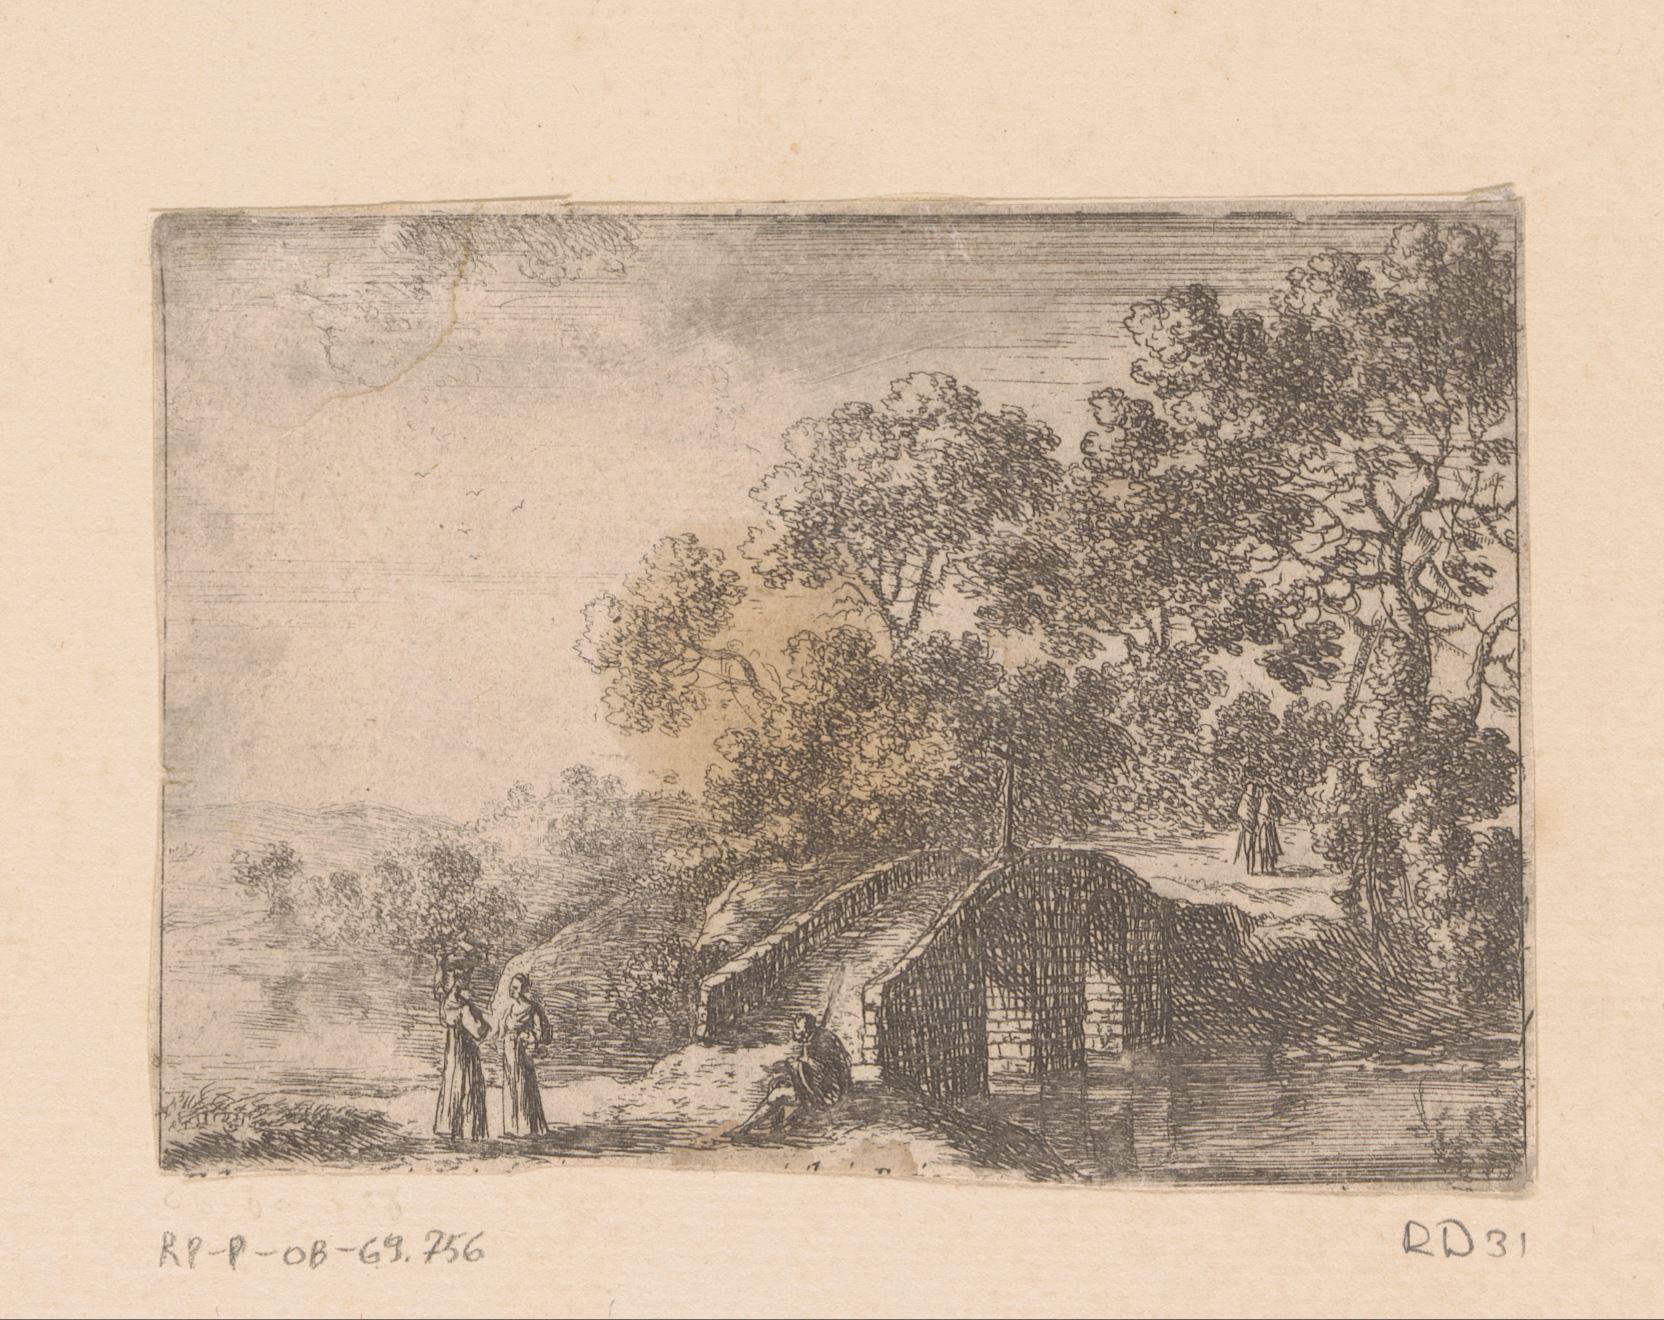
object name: print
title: Landschap met stenen brug met kruis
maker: henri mauperché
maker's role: painter, print maker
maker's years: 1602-1686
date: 1612-1686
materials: paper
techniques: etching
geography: paris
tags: bridge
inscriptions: collector's mark: Lugt 2228, watermark